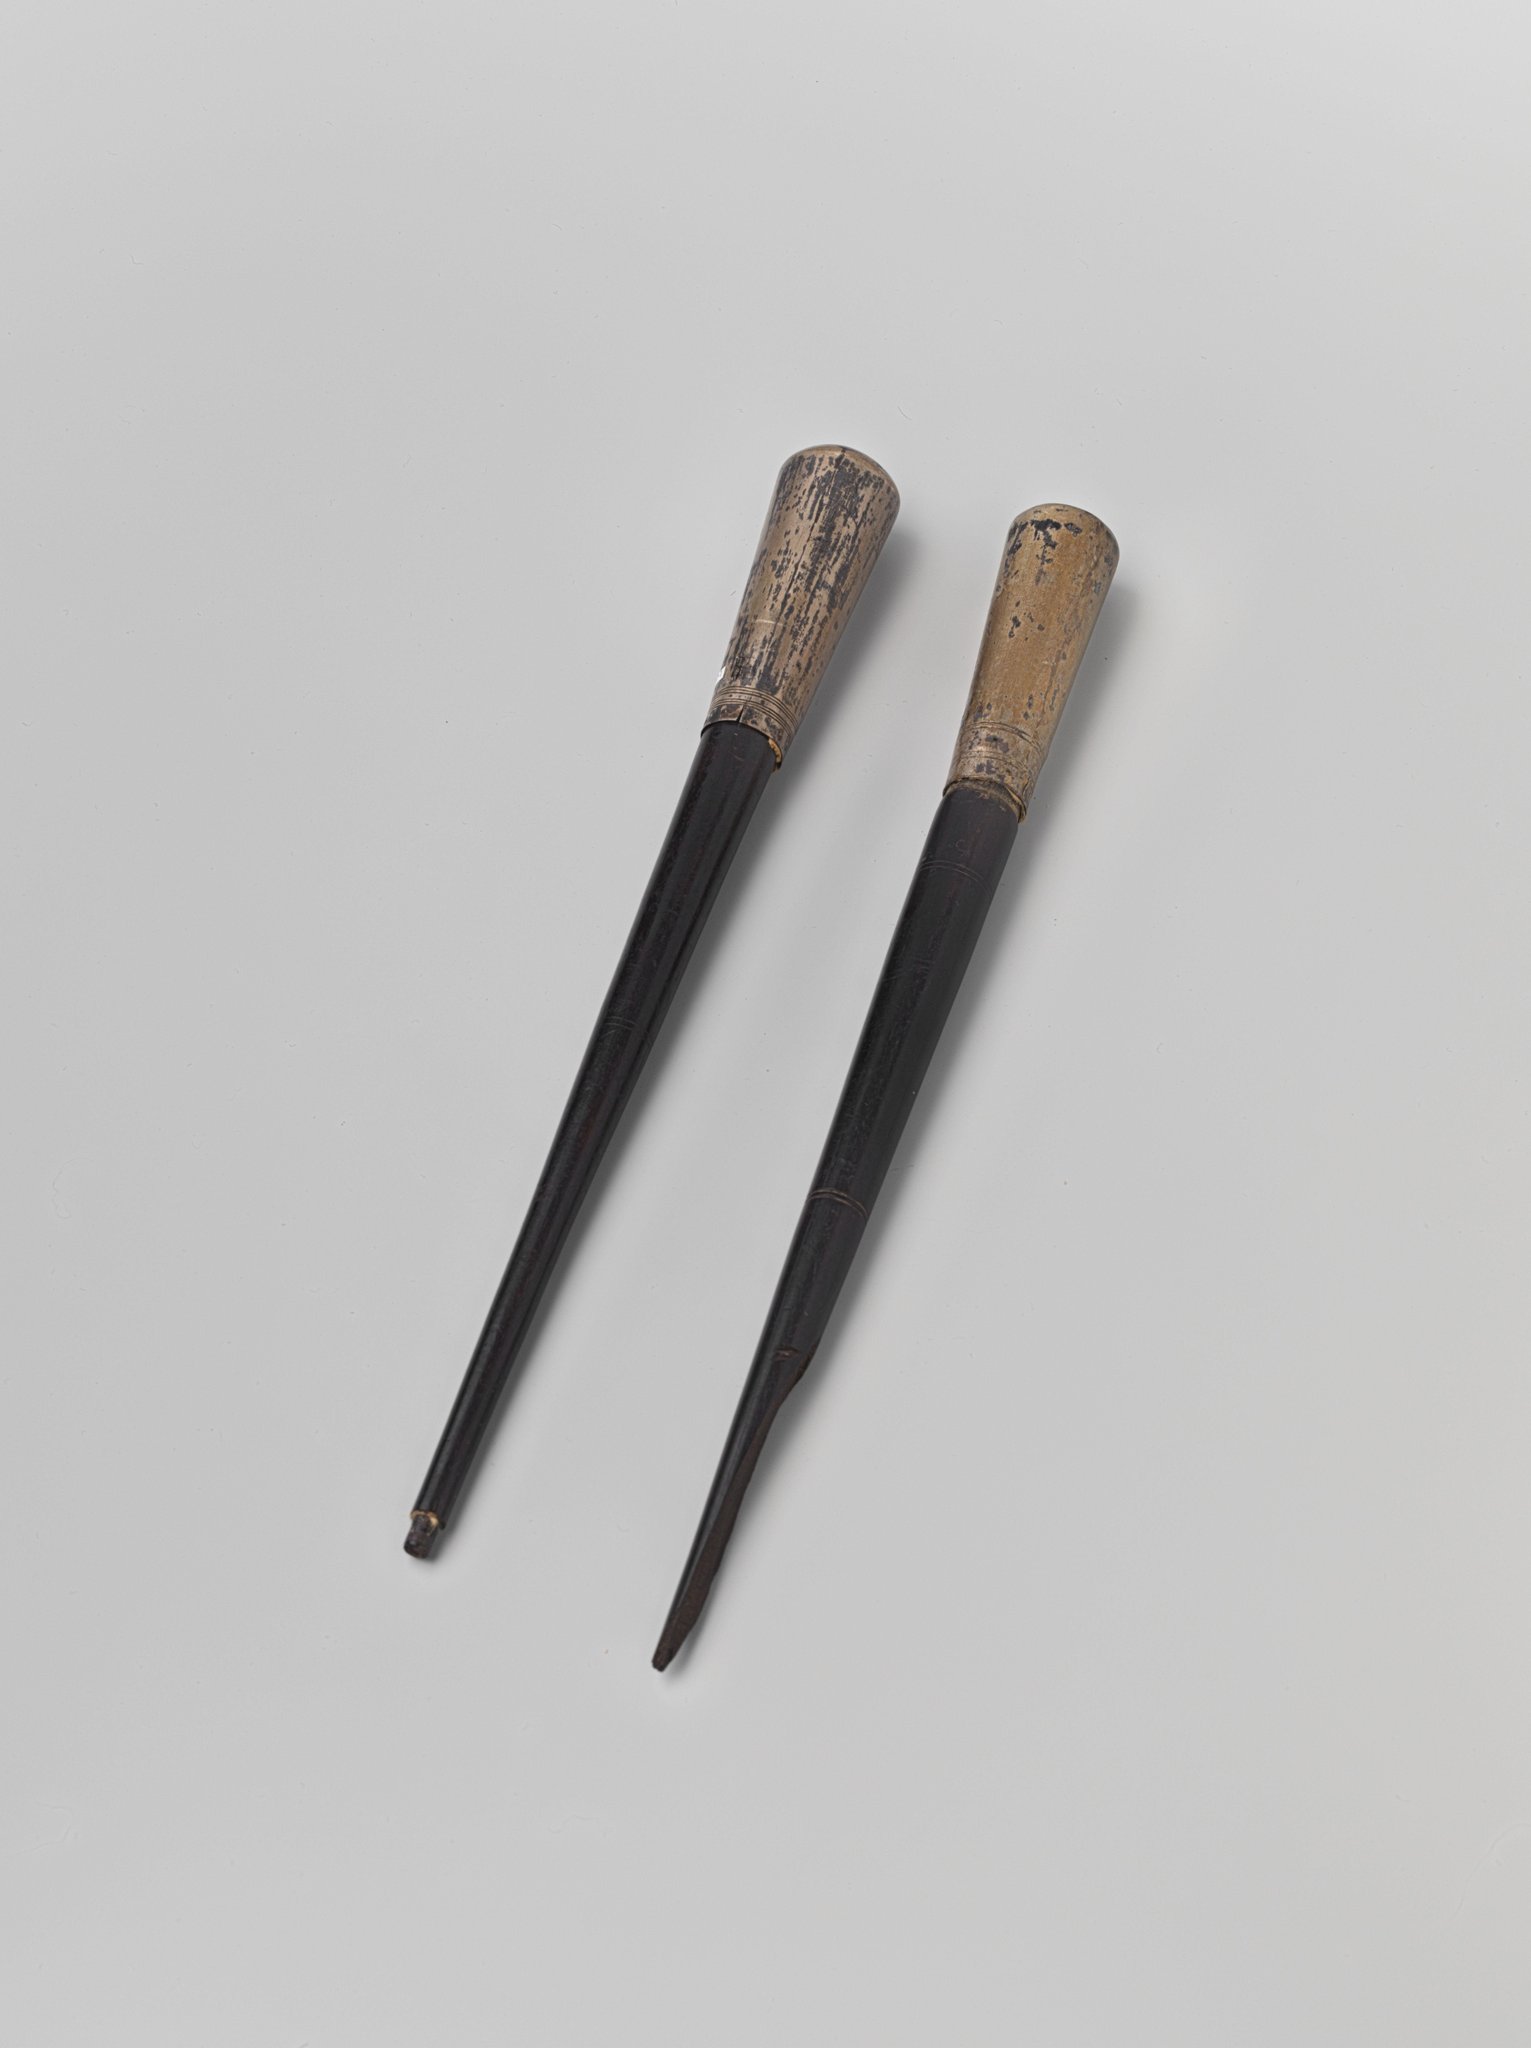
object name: percussion instrument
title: Drumsticks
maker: Anonymous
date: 1817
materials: wood, ivory, silver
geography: netherlands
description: Een ebbenhouten tromstok; de ivoren knop ontbreekt. Het hout is gesplinterd.